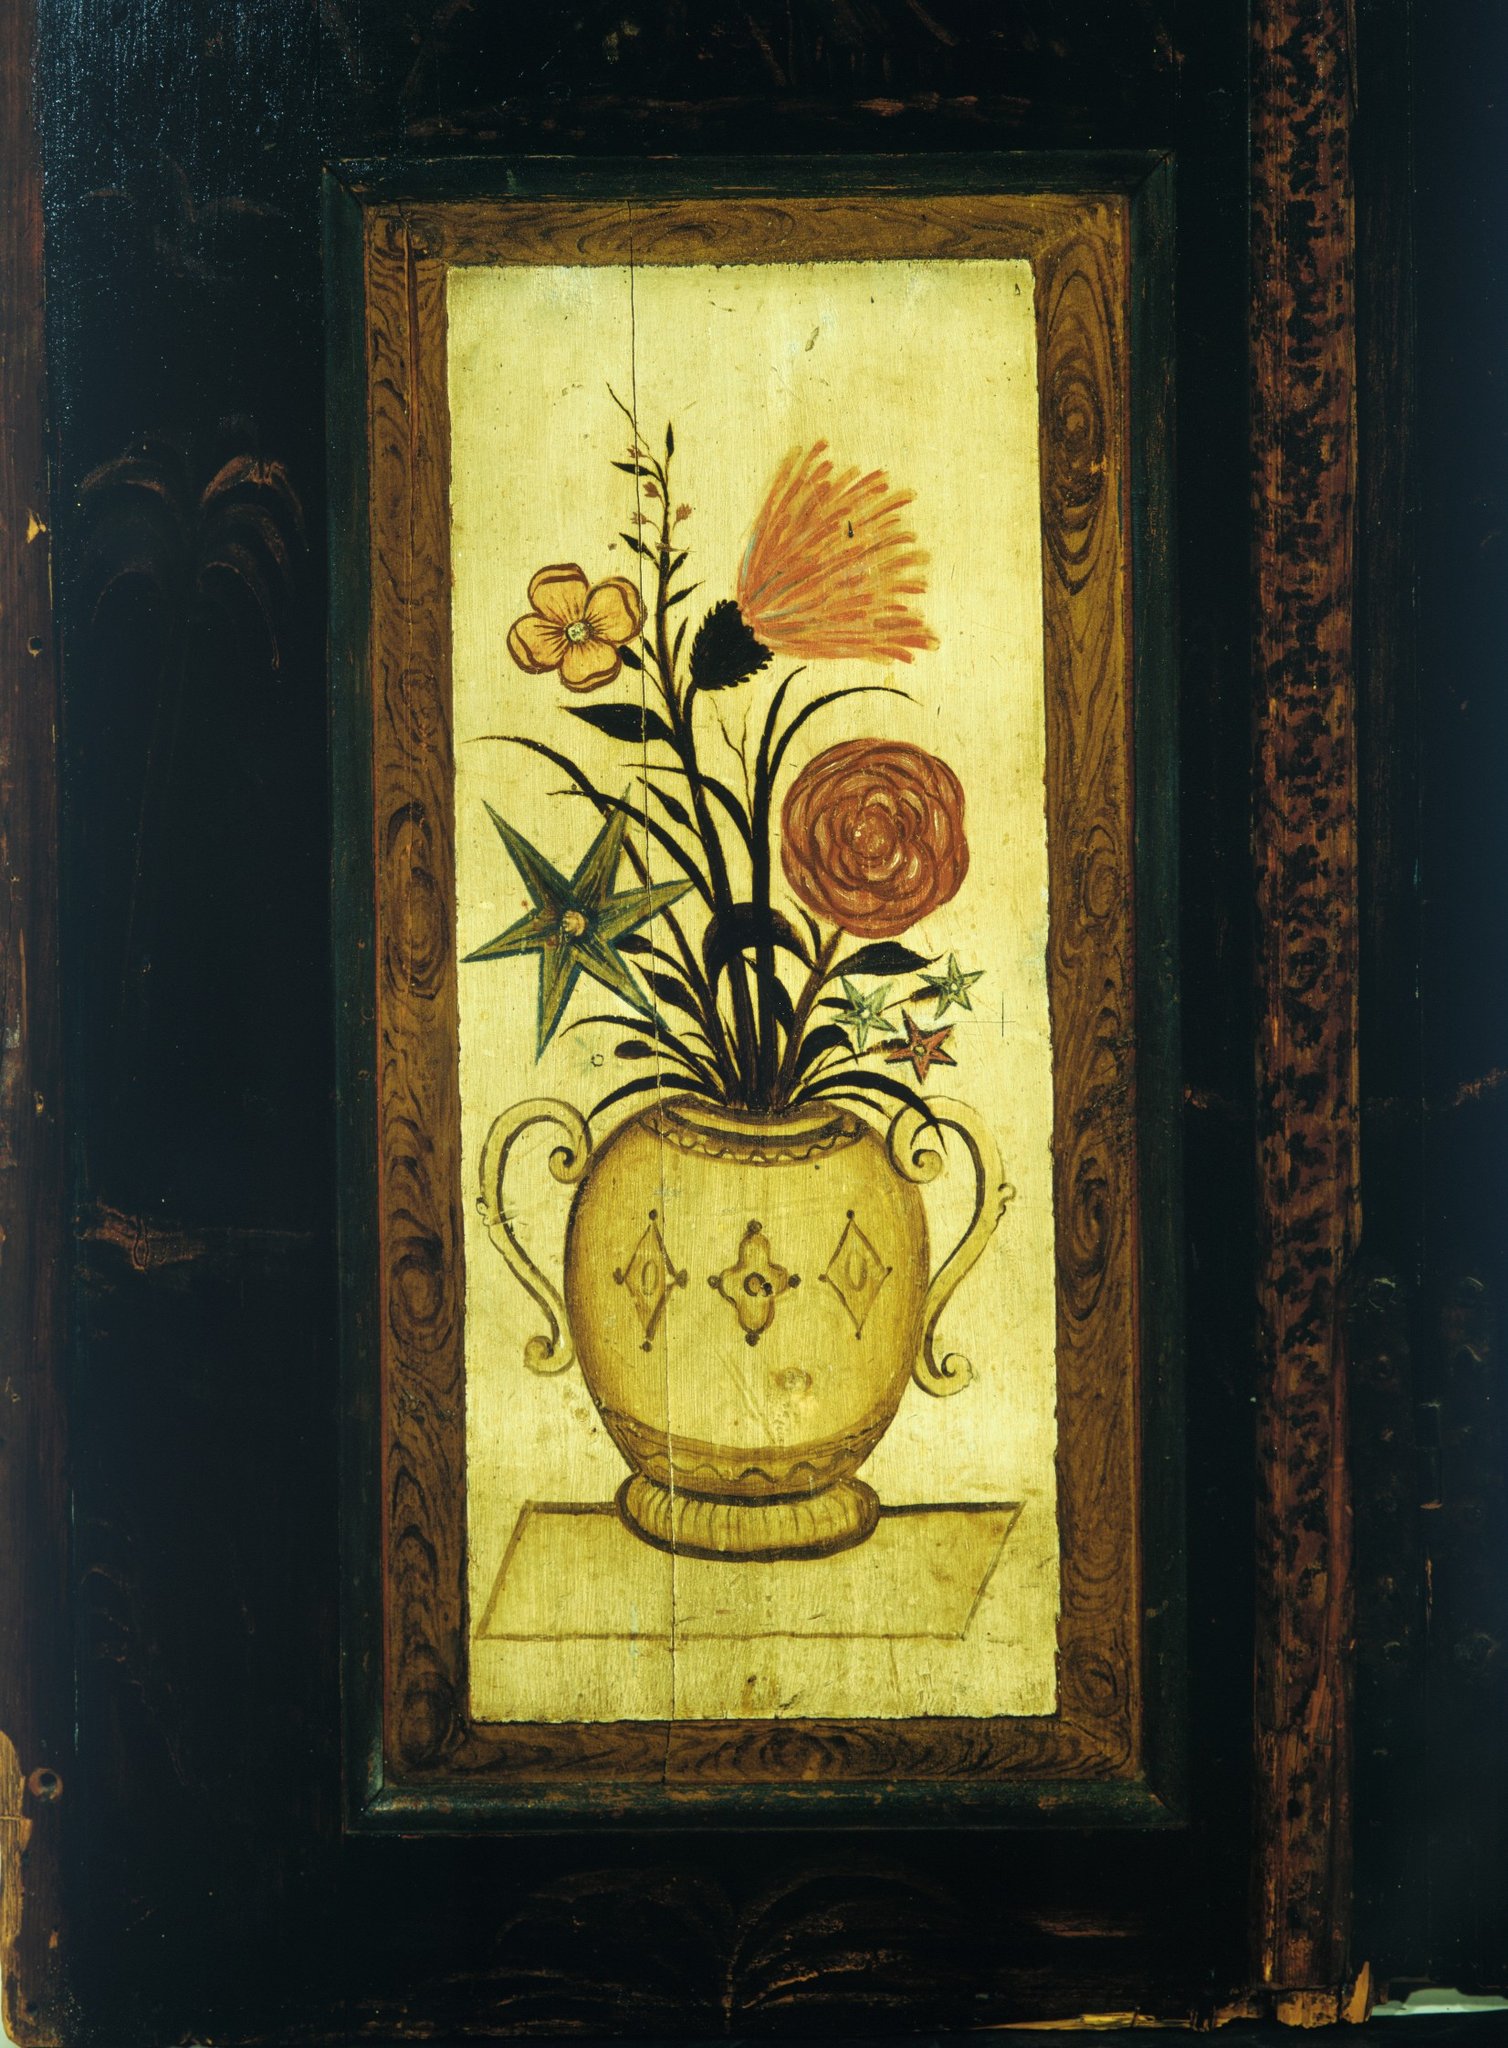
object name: door panel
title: Panels and Door from the Hoagland Farm, Griggstown, New Jersey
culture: american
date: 1760-1790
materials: wood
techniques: painting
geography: united states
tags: flowers